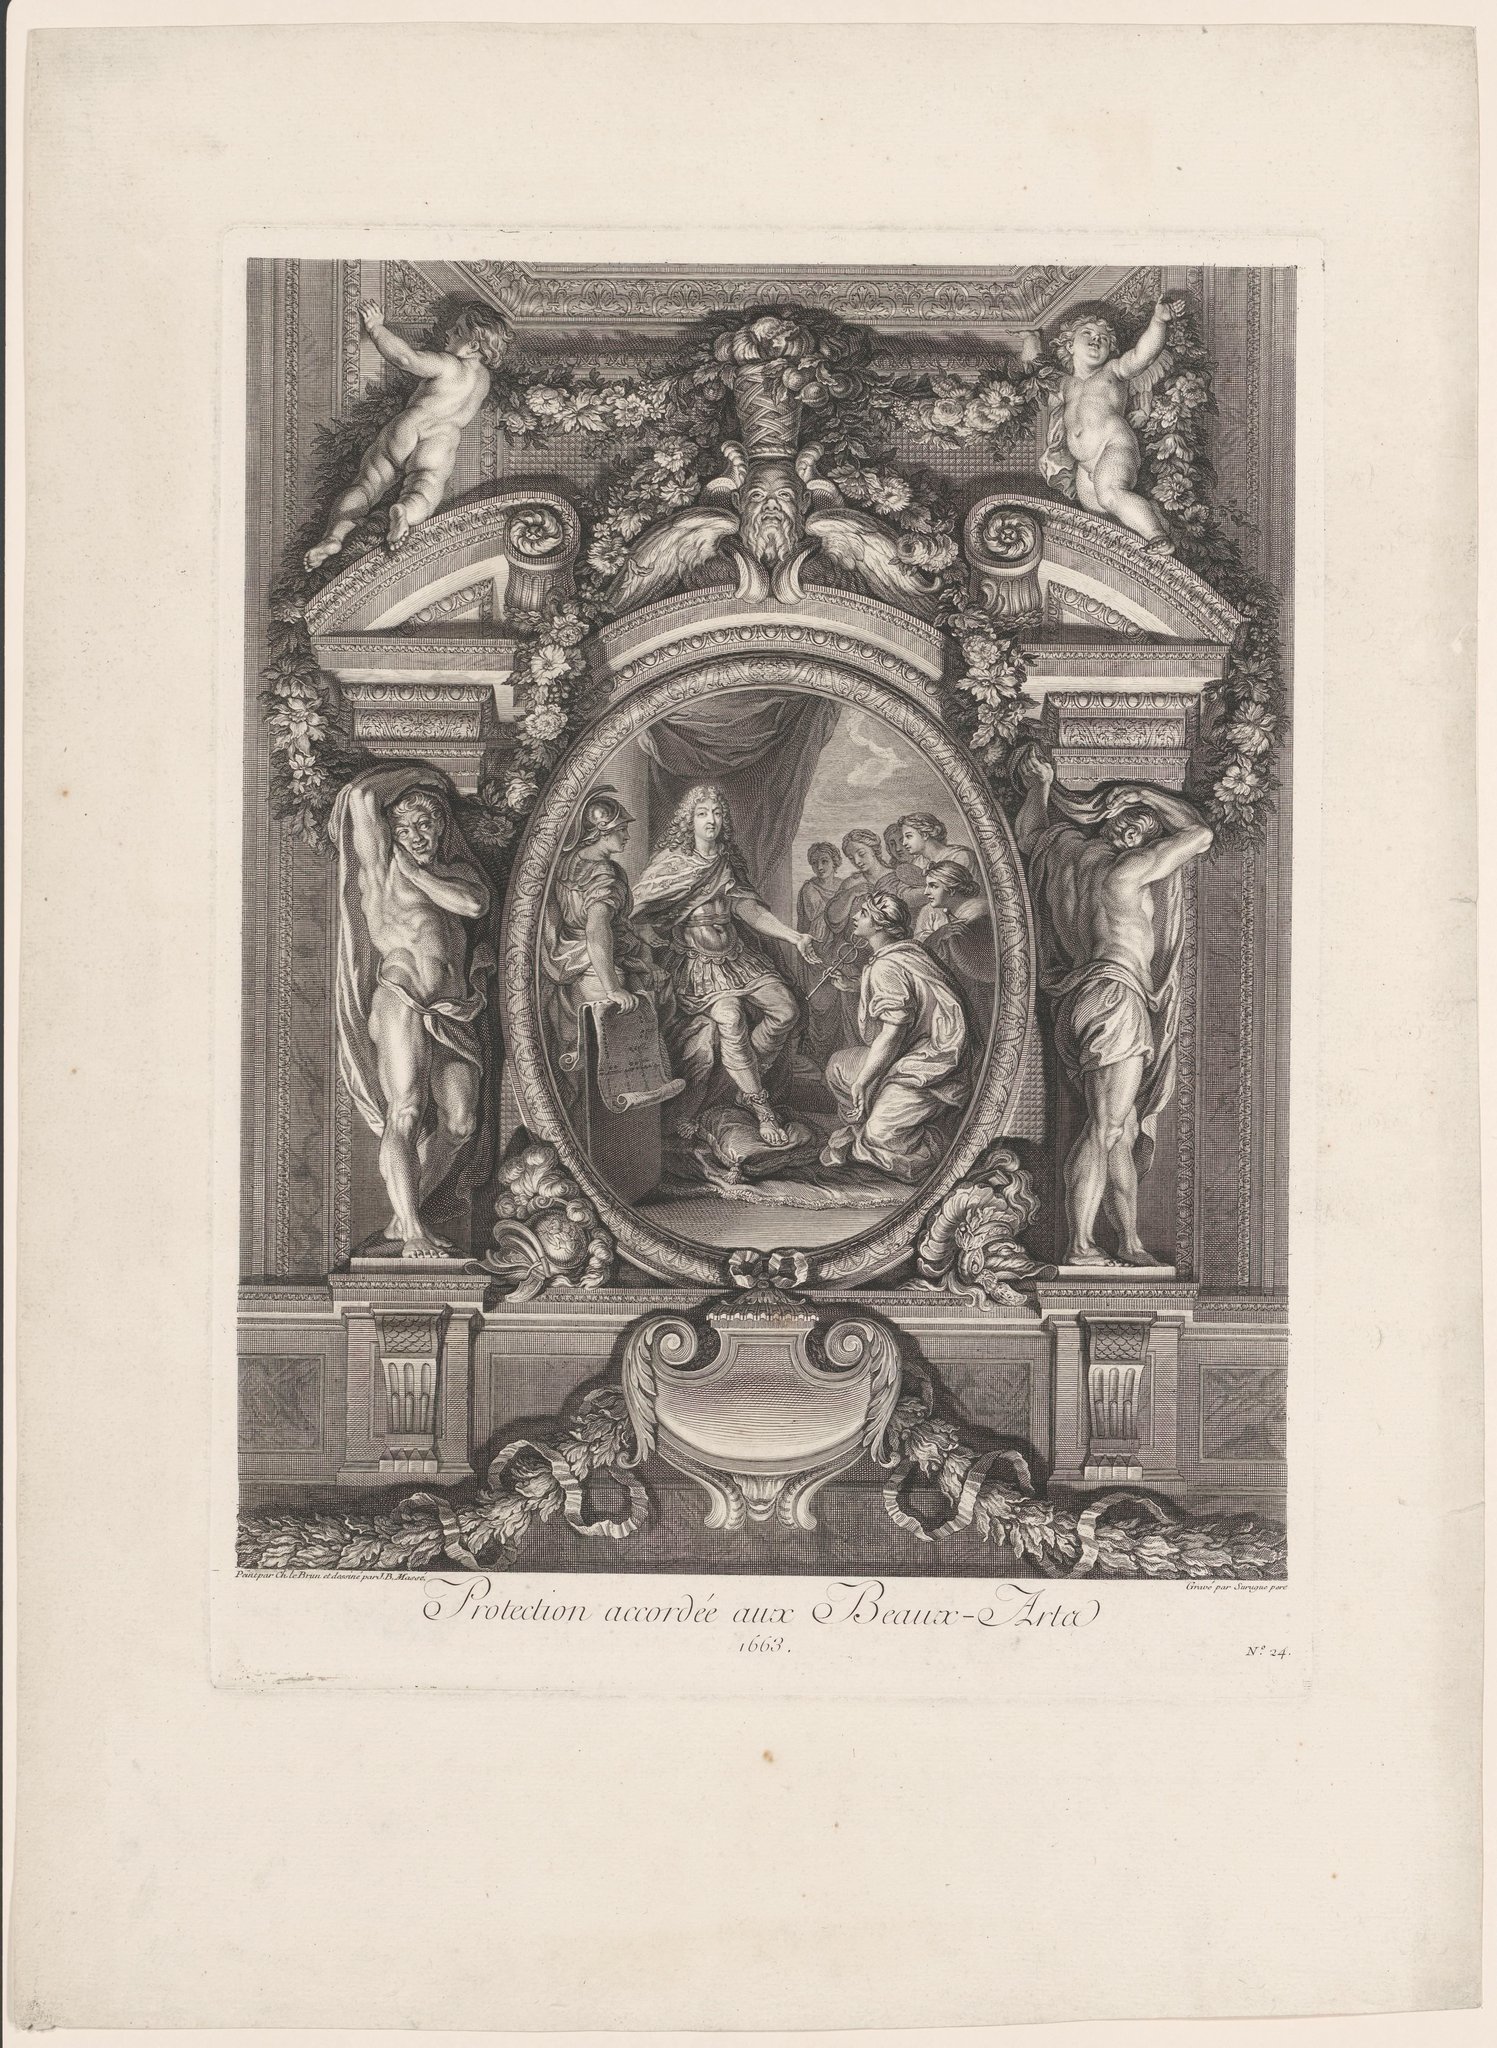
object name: print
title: Protection accordée aux Beaux-Arts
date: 1752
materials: paper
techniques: engraving, etching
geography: france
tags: lodewijk xiv (koning van frankrijk), minerva as patroness, eloquence; 'eloquenza', 'fermezza & gravità dell'oratione' (ripa), the muses acting together (as group)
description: Prent uit: Massé, Jean Baptiste. La Grande Galerie de Versailles, et les deux salons qui l'accompagnent, peints par Charles le Brun premier peintre de Louis XIV, dessinés par Jean- Baptiste Masse peintre et conseiller de l'Academie royale de peinture & sculpture; et gravés sous ses yeux par les meilleurs maitres du tems. Parijs: Imprimerie Royale, 1752.